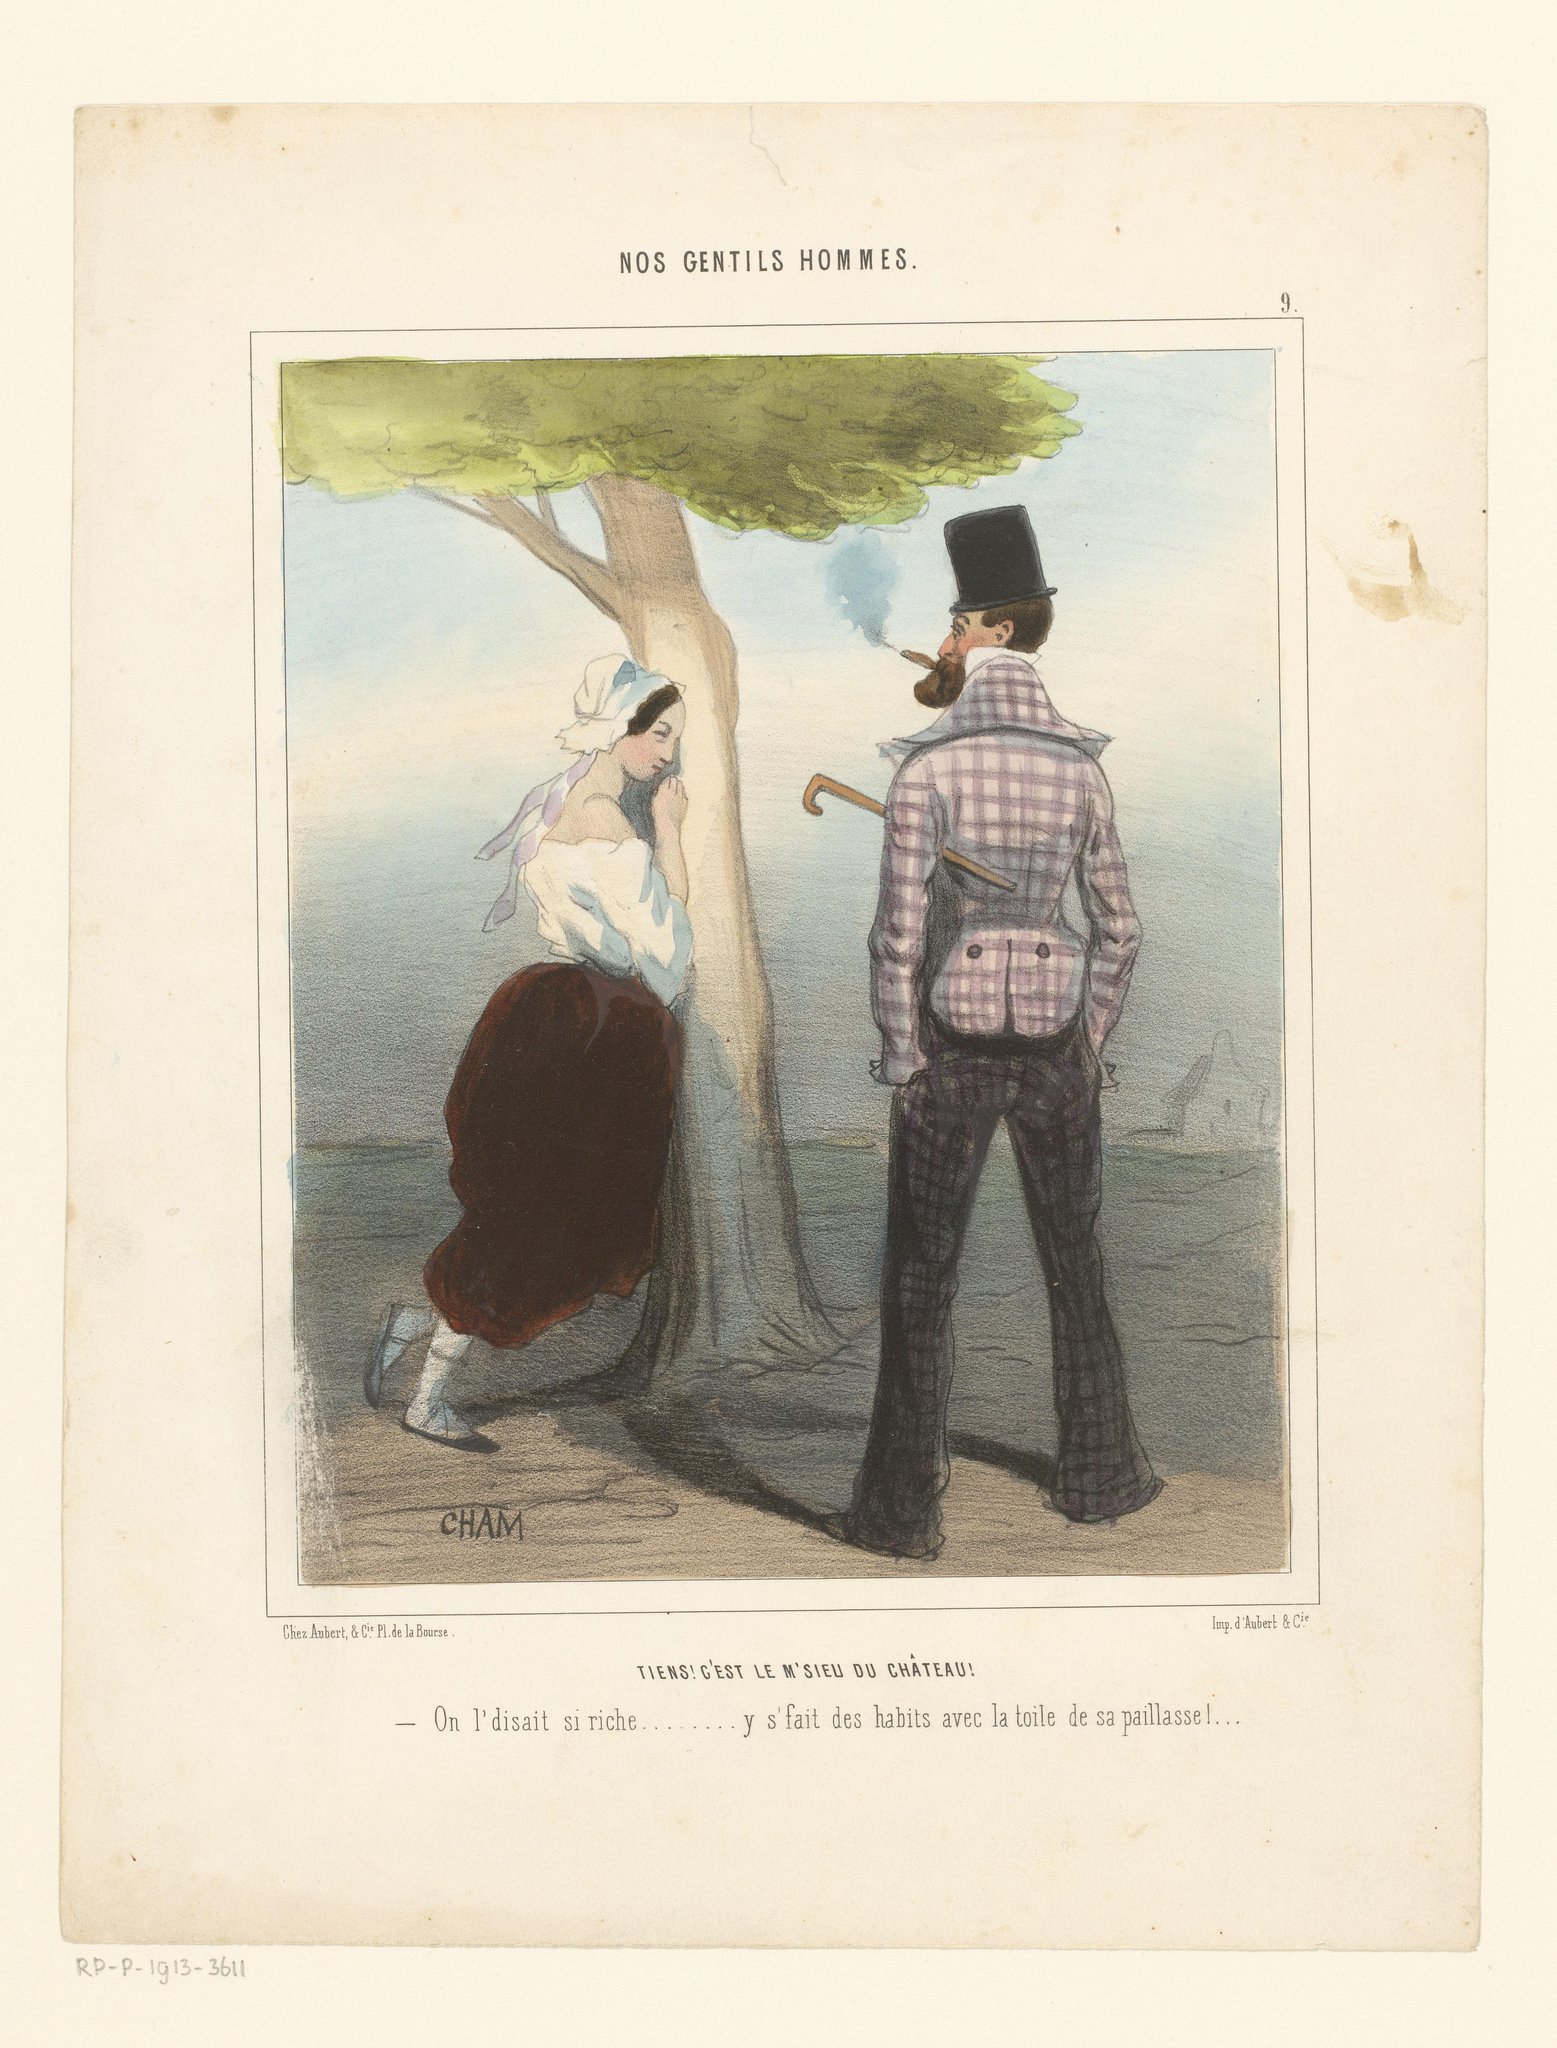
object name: print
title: Vrouw staat verdrietig bij een boom vergezeld door een man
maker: cham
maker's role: print maker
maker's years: 1818-1879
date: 1846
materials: paper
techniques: hand coloring, lithograph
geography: paris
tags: fashion, clothing, head-gear, walking-stick, staff, female sex; woman, adult man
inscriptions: collector's mark: Lugt 2233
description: Prent verschenen in: Le Charivari 15 (1846), nr. 164, 13 juni 1846.